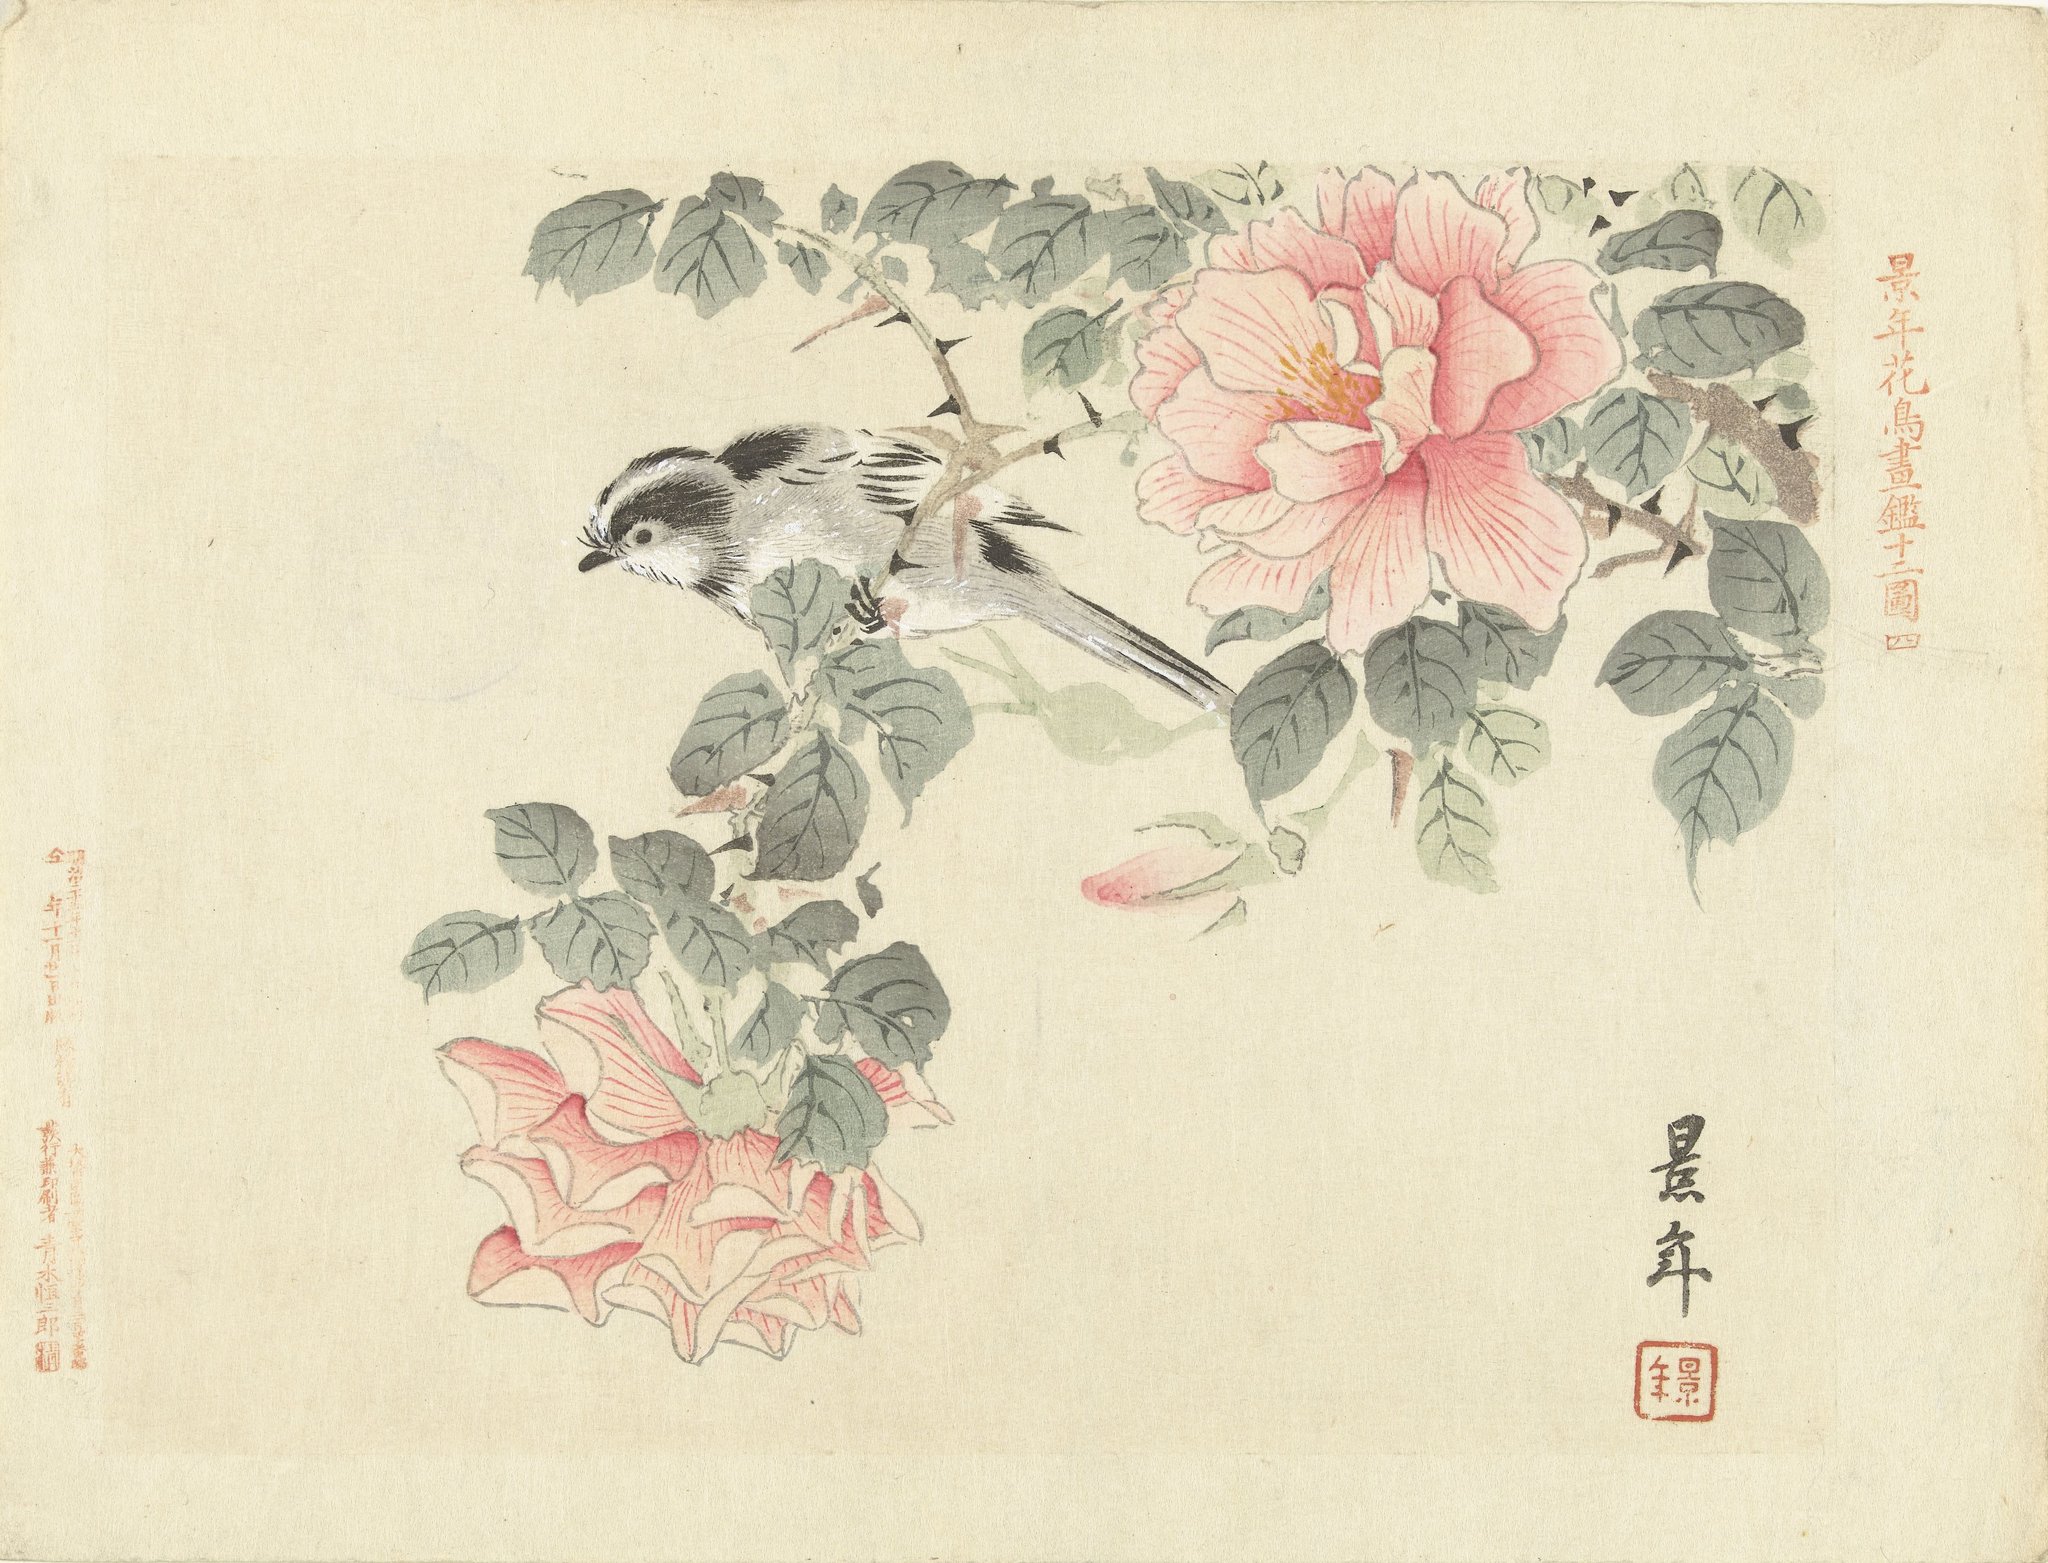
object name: print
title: Keinen kacho gafu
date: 1811-1892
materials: paper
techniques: woodcut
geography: osaka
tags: birds, flowers: rose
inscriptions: collector's mark: Lugt 2228, collector's mark: ‘Rijksschool voor kunstnijverheid’ Lugt 3937